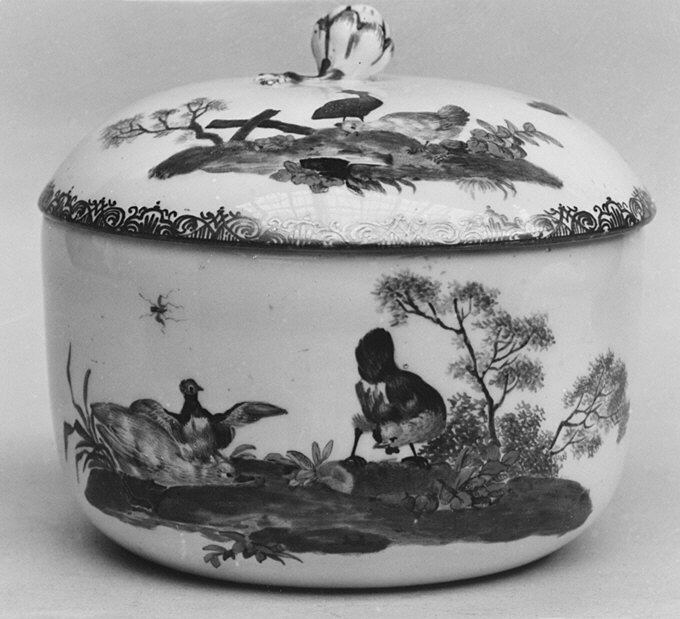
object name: bowl with cover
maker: meissen manufactory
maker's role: manufactory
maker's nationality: german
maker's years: 1710-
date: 1765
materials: hard paste porcelain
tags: birds,trees